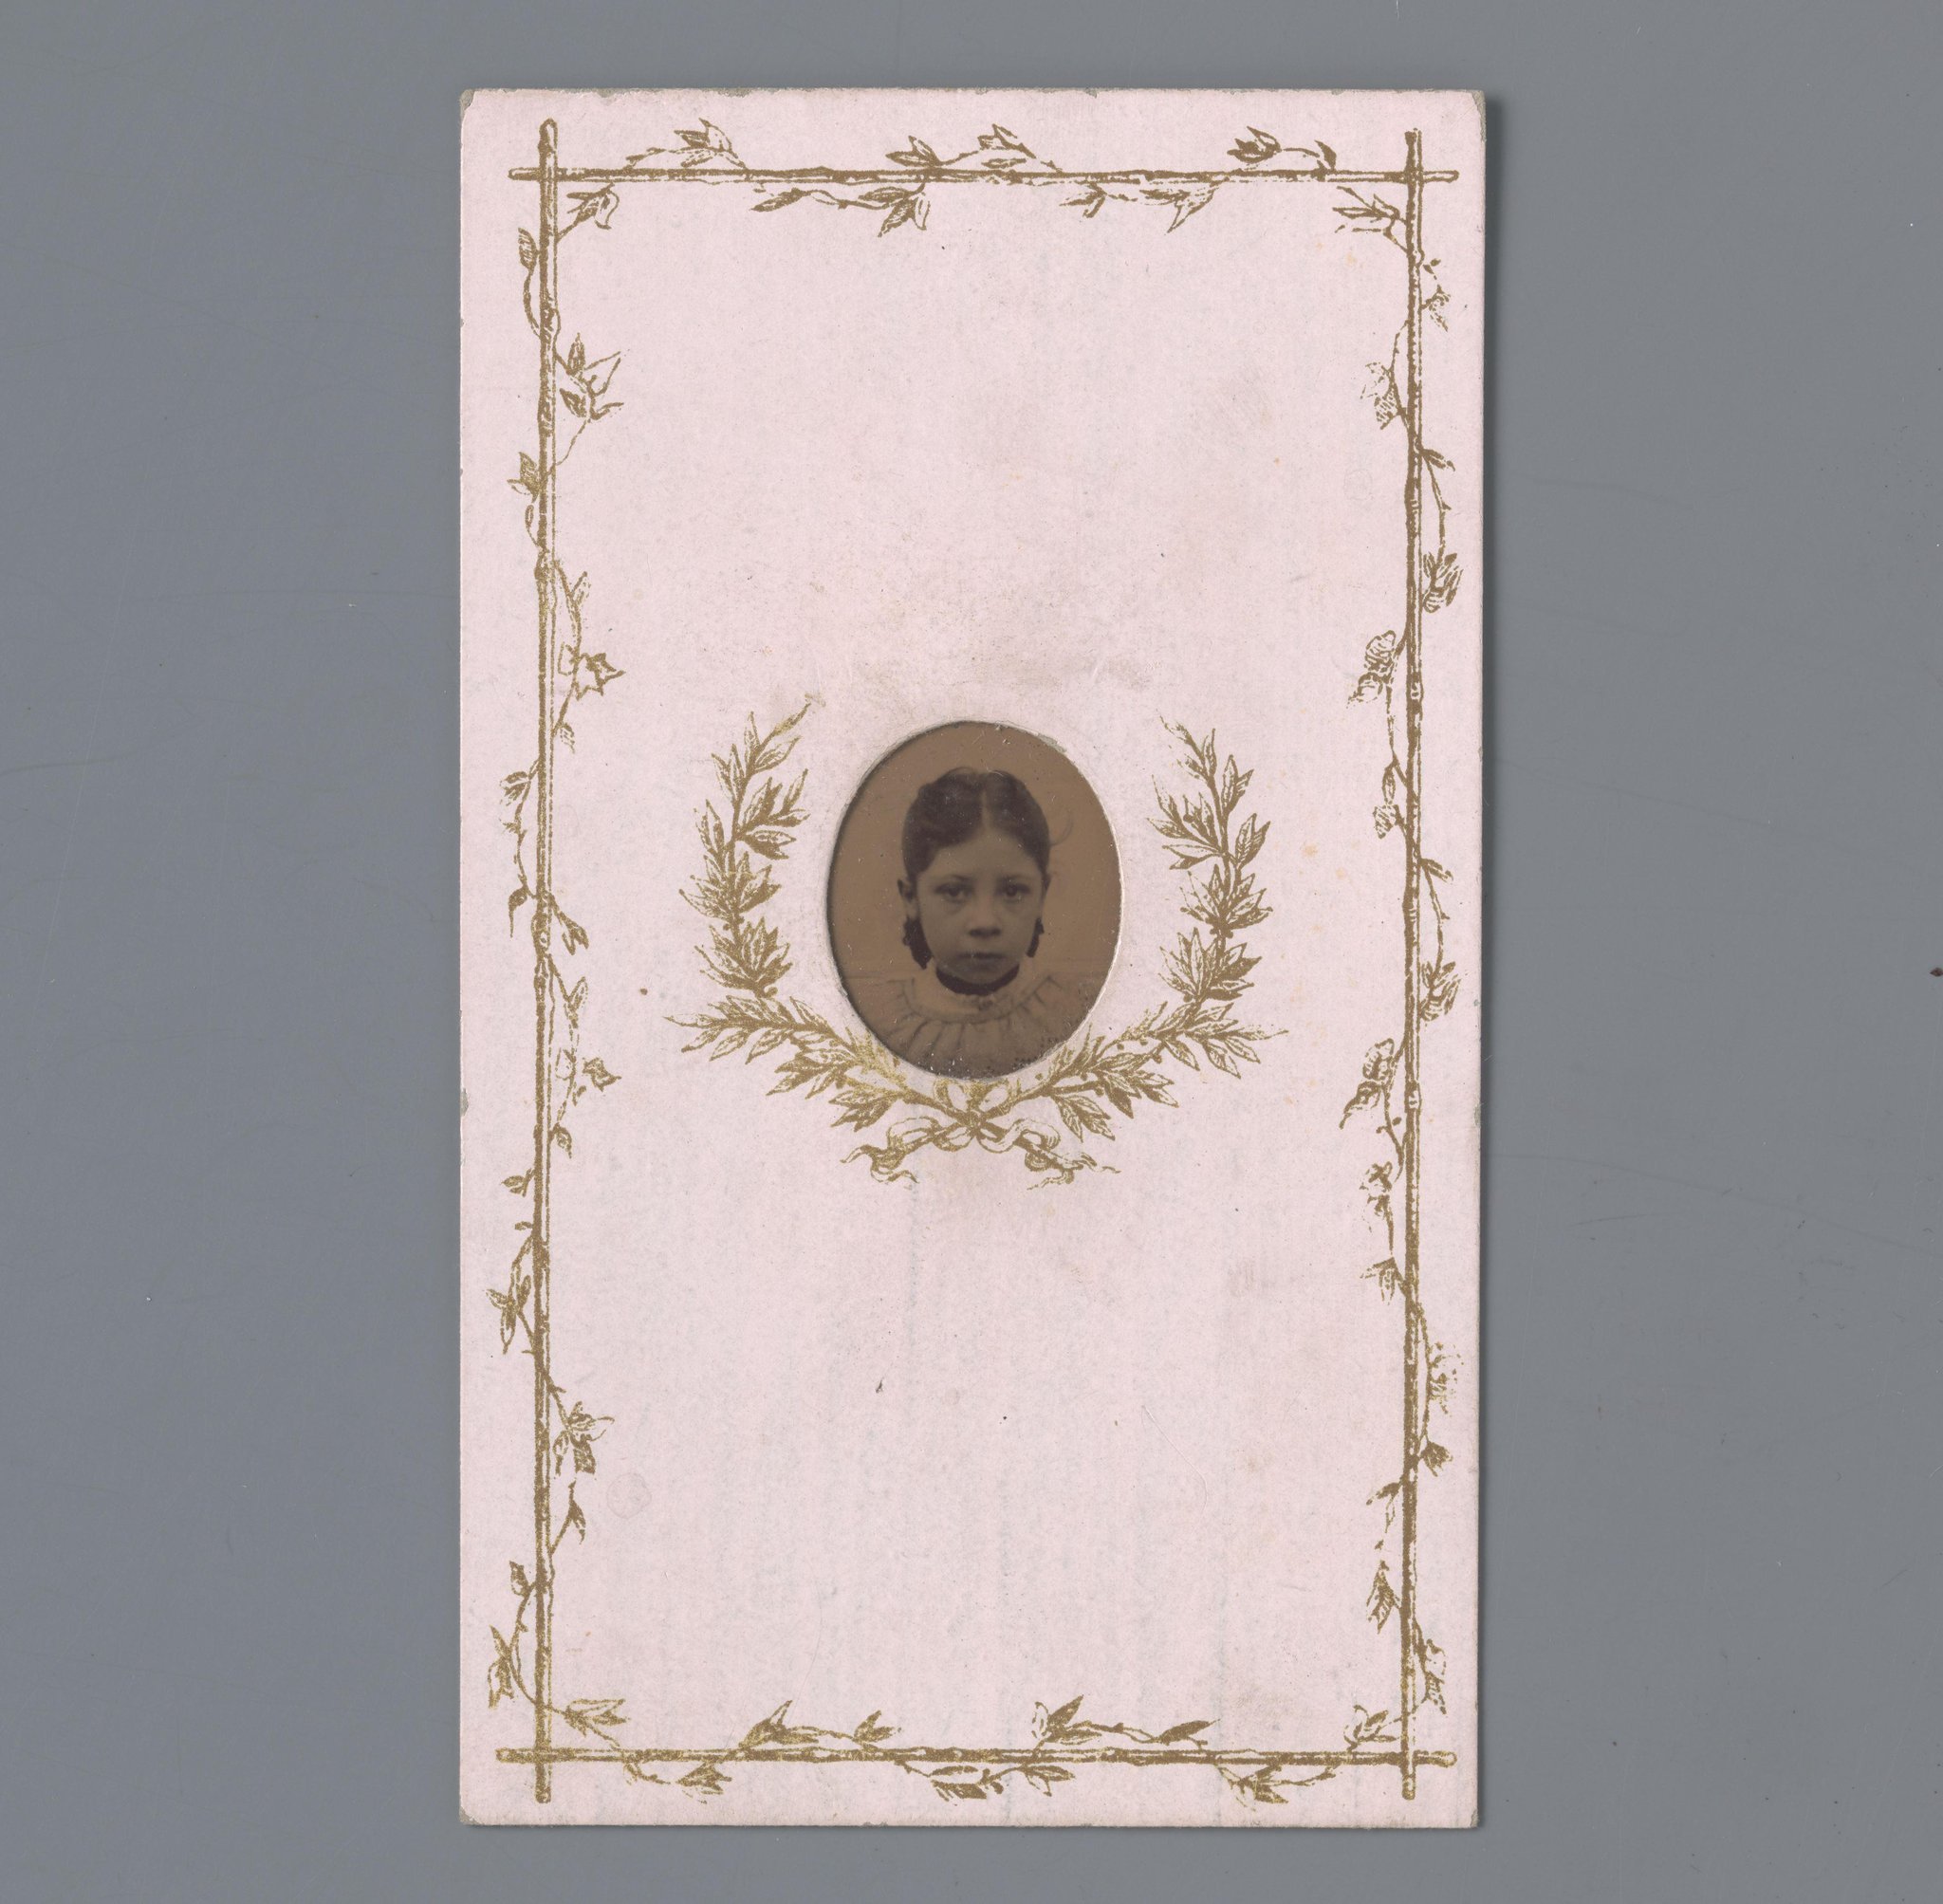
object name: photograph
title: Portret van een onbekend meisje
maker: Anonymous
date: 1855-1900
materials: cardboard, iron, paper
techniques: ferrotyping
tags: historical persons - bb - woman, girl (child between toddler and youth)